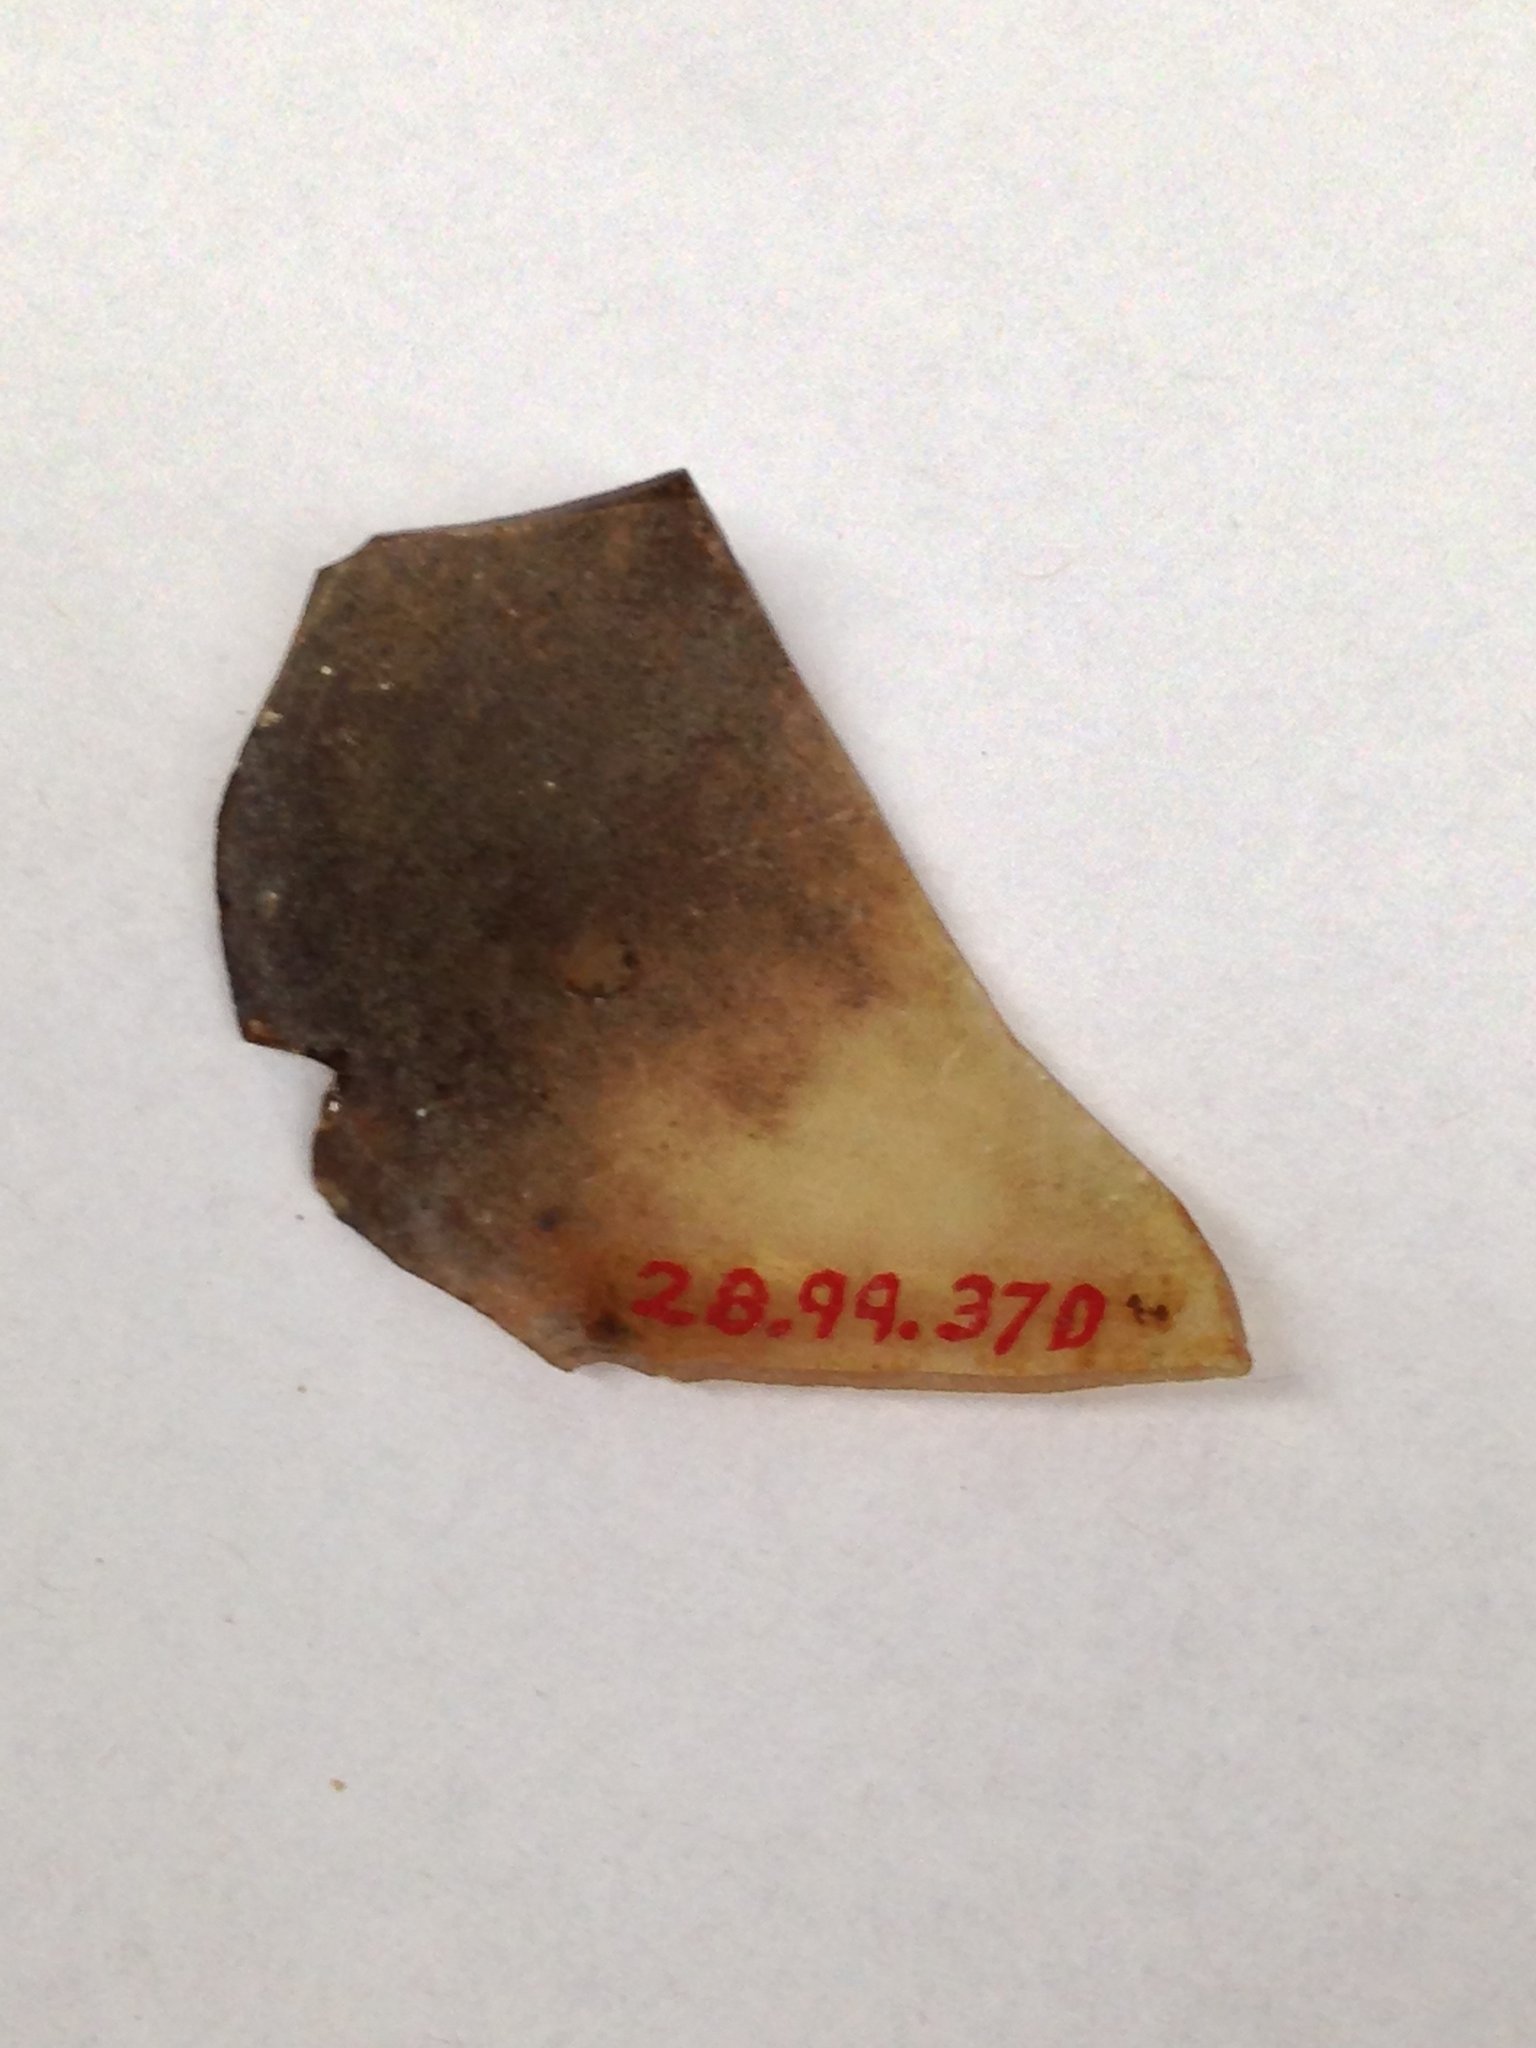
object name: fragment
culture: european or middle eastern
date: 1150-1250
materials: ceramic, glass